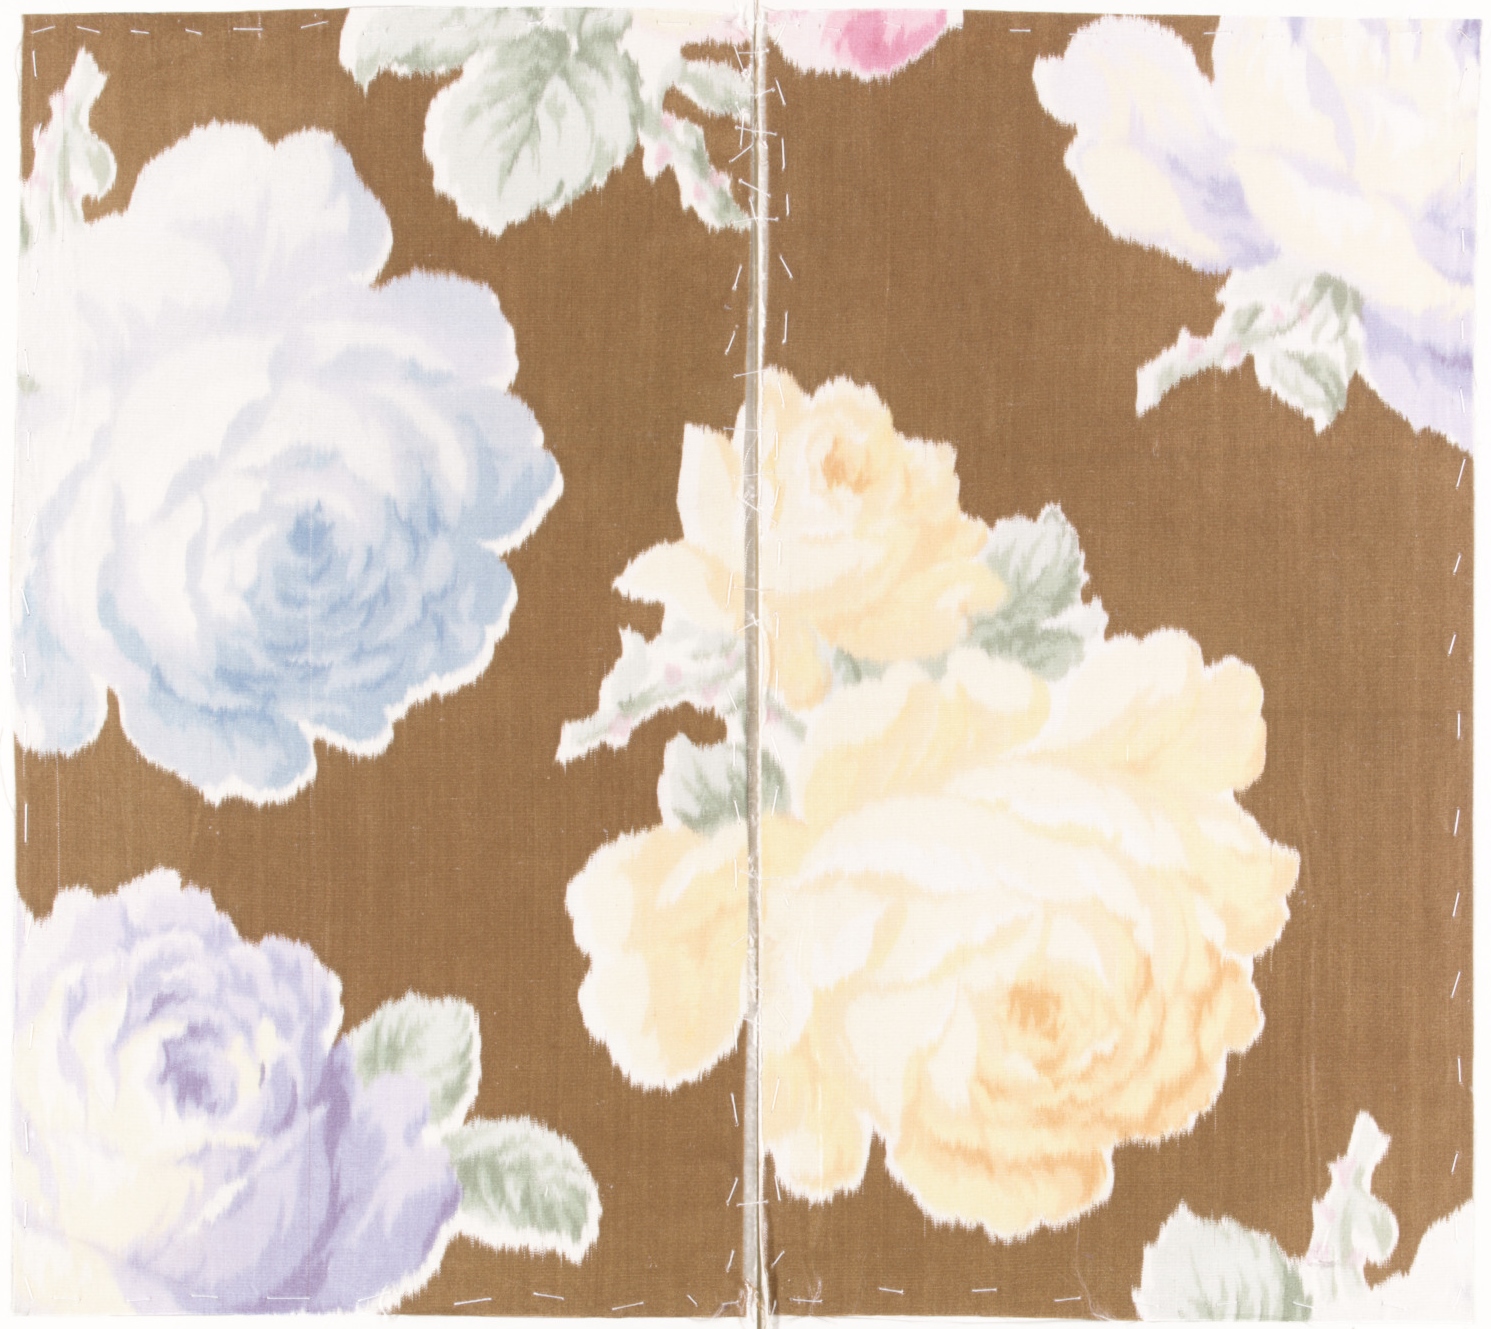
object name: textile sample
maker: Anonymous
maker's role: designer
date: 1900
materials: silk